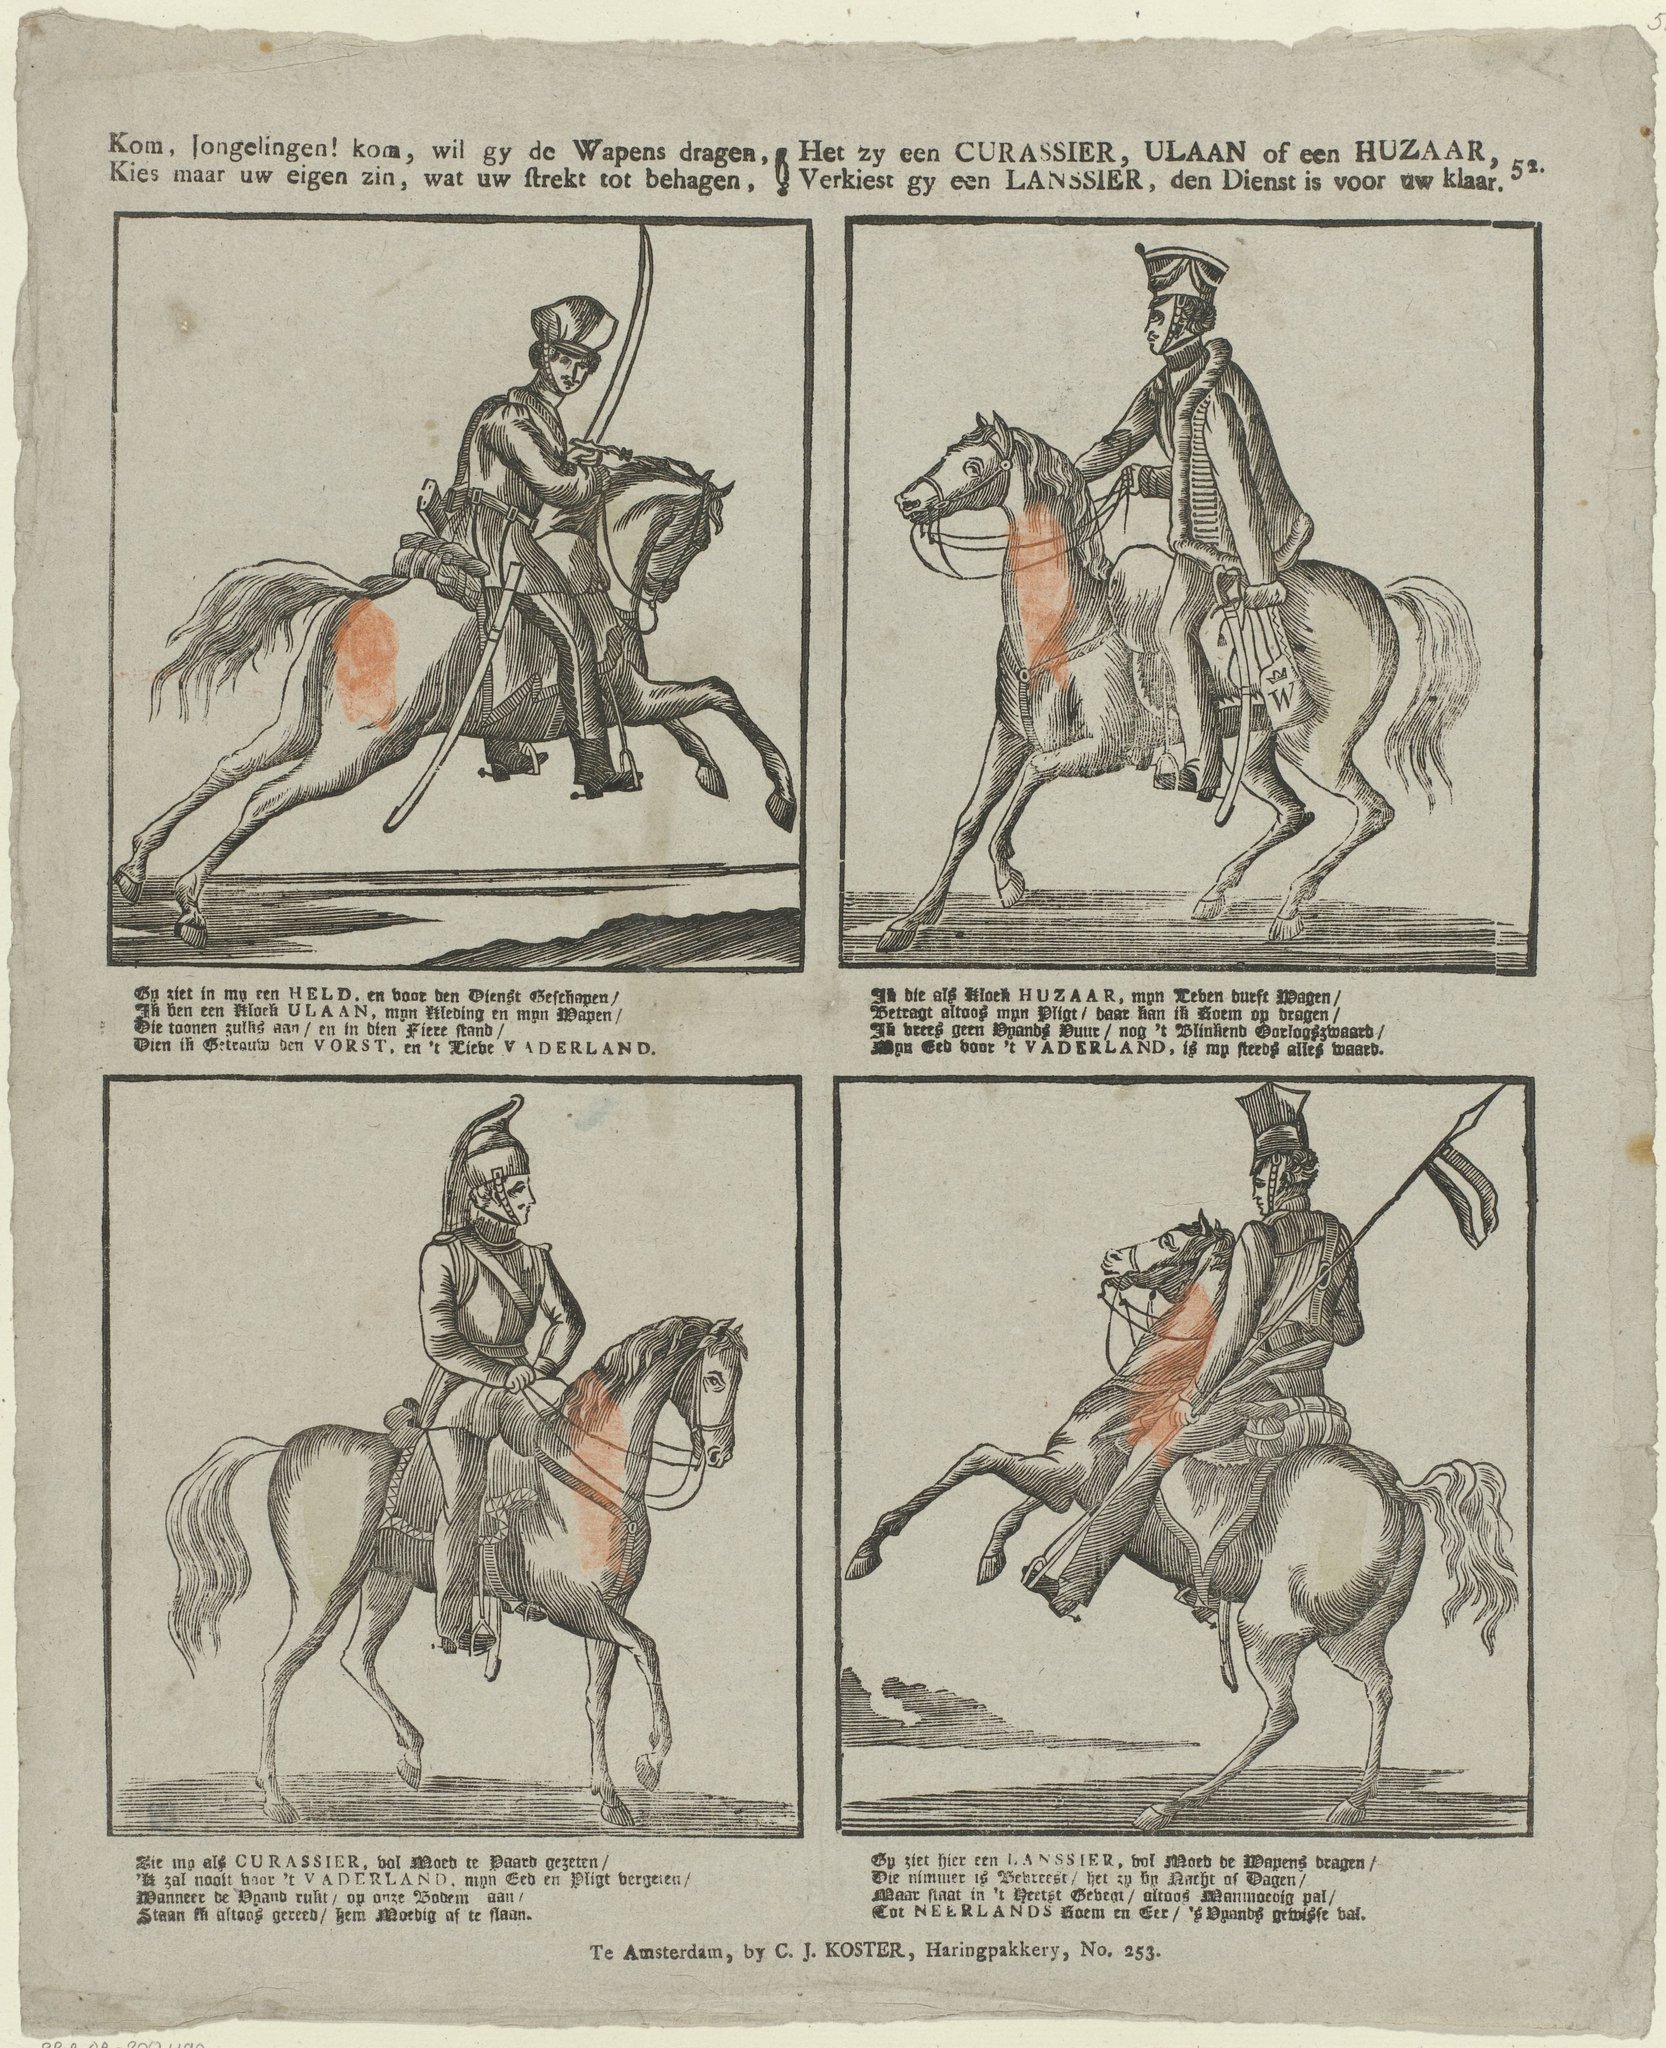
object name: print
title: Komt, jongelingen komt, wilt gy de wapens dragen, / Kies maar uw eigen zin, wat uw strekt tot behagen, / Het zy een curassier, ulaan of een huzaar, / Verkiest gy een lanssier, de dienst is voor uw klaar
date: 1842-1866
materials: paper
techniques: colour, letterpress printing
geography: netherlands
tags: warfare; military affairs (+ cavalry, horsemen), the soldier; the soldier's life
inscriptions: collector's mark: Lugt 2760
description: Blad met 4 voorstellingen van militairen te paard. Onder elke afbeelding een vierregelig vers. Genummerd rechtsboven: 52.